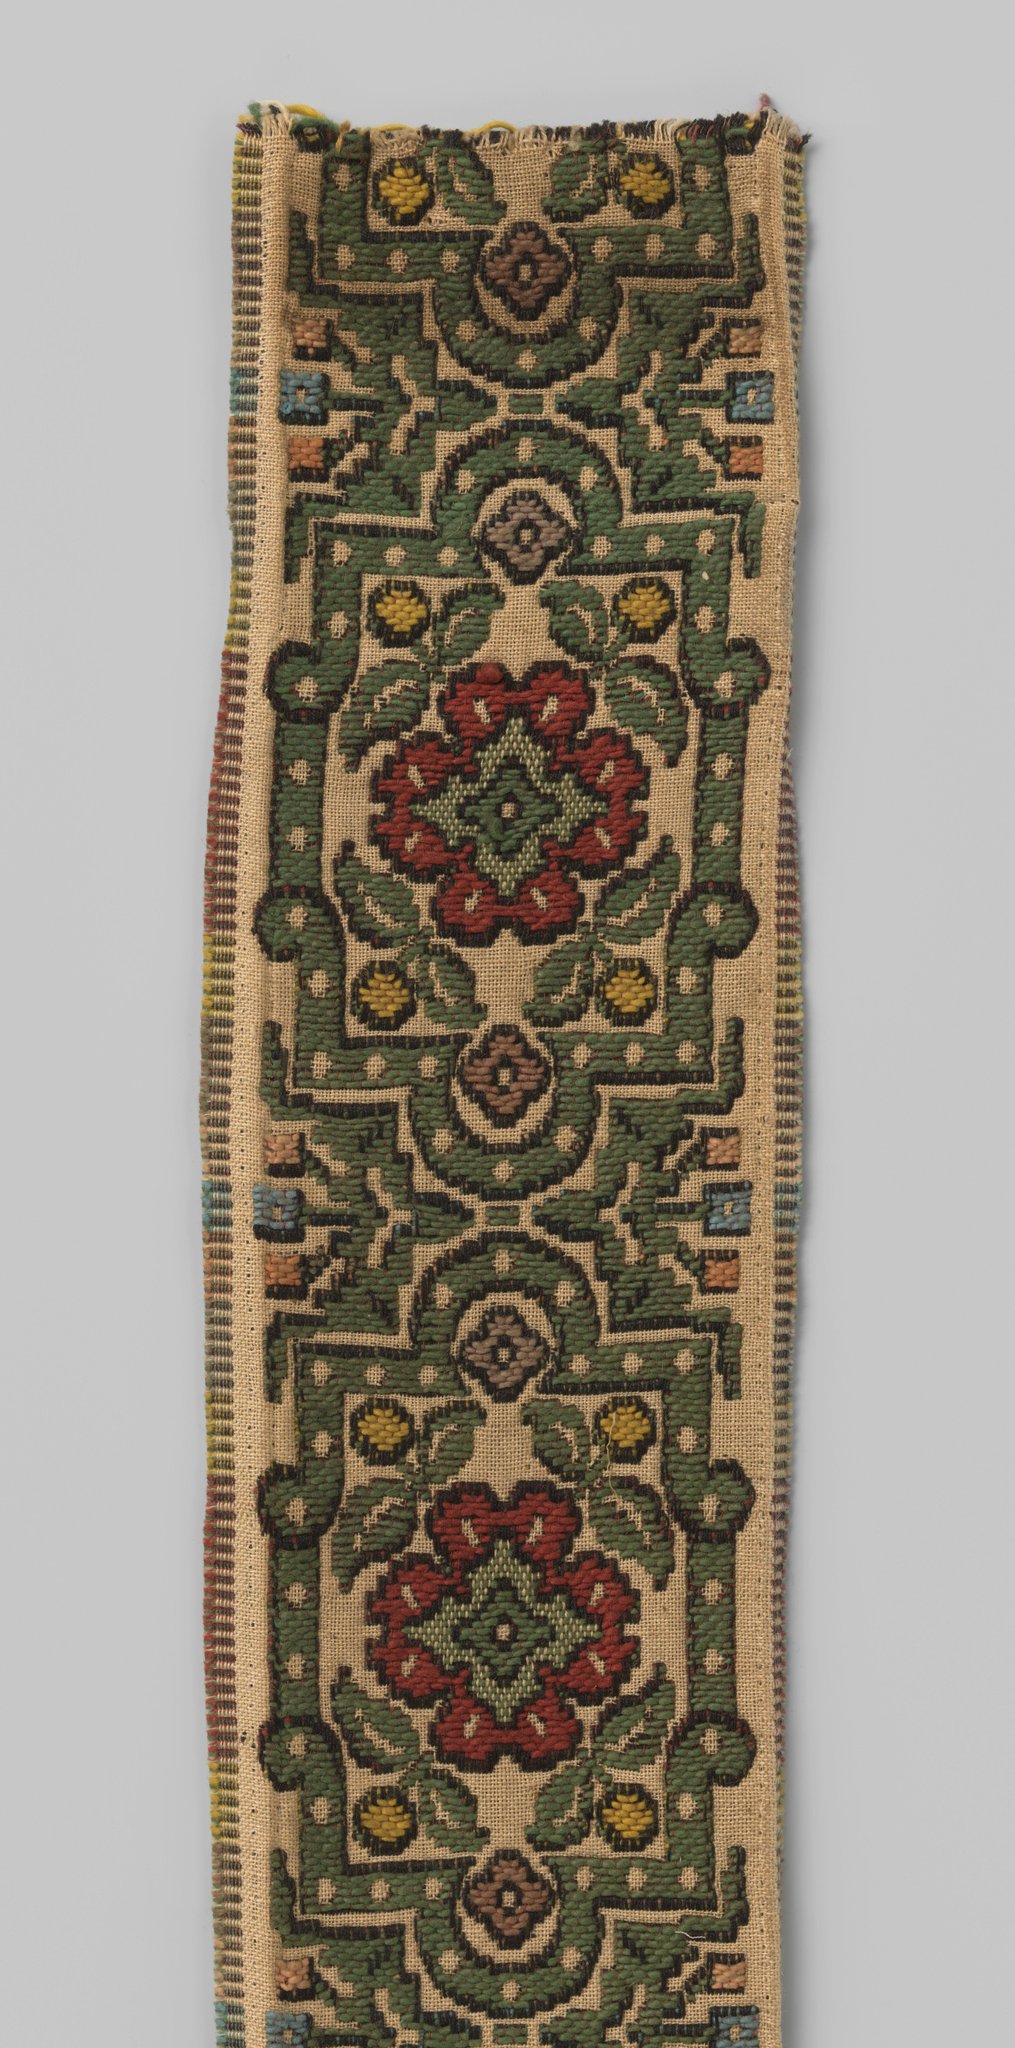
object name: galloon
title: Gordijngalon van geweven imitatie Berlijns borduurwerk, dat op een grauw fond staande cartouches met groene omlijsting en donkerrode rozetbloem vertoont.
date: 1880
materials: galloon, textile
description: Gordijngalon van geweven imitatie Berlijns borduurwerk, dat op een grauw fond staande cartouches met groene omlijsting en donkerrode rozetbloem vertoont.